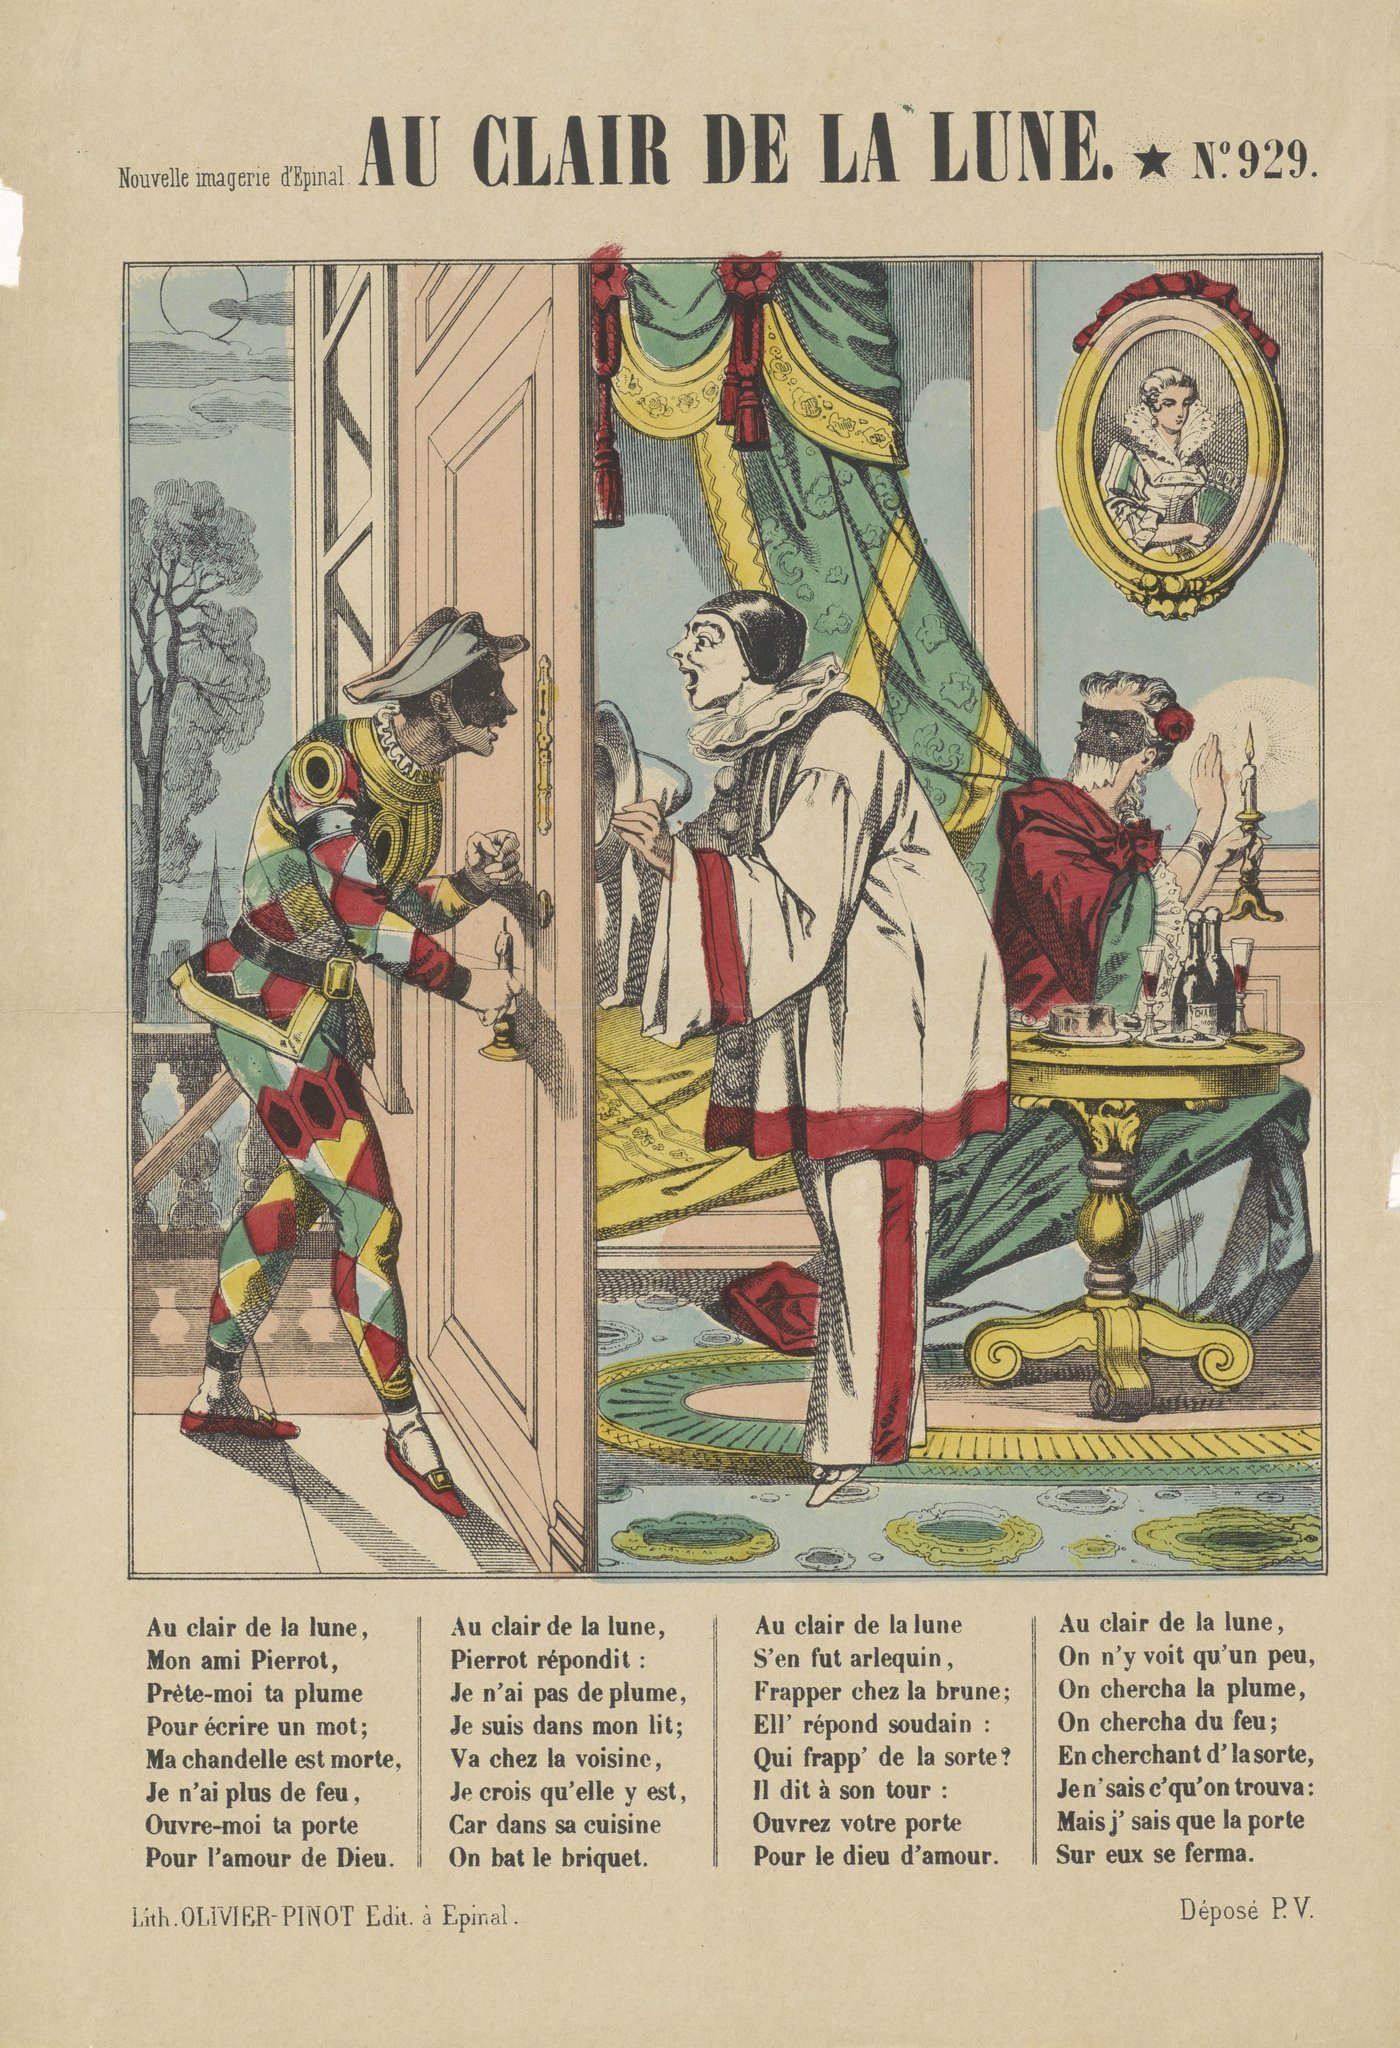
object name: popular print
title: Au clair de la lune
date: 1874-1888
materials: paper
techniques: colour, letterpress printing, lithograph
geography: europe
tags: types in 'commedia dell'arte': pierrot, types in 'commedia dell'arte': harlequin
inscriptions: collector's mark: Lugt 2760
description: Harlekijn staat voor de deur van Pierrot, die doet alsof hij niet thuis is. Onder de voorstelling een onderschrift in het Frans in vier kolommen. Genummerd rechtsboven: No. 929.